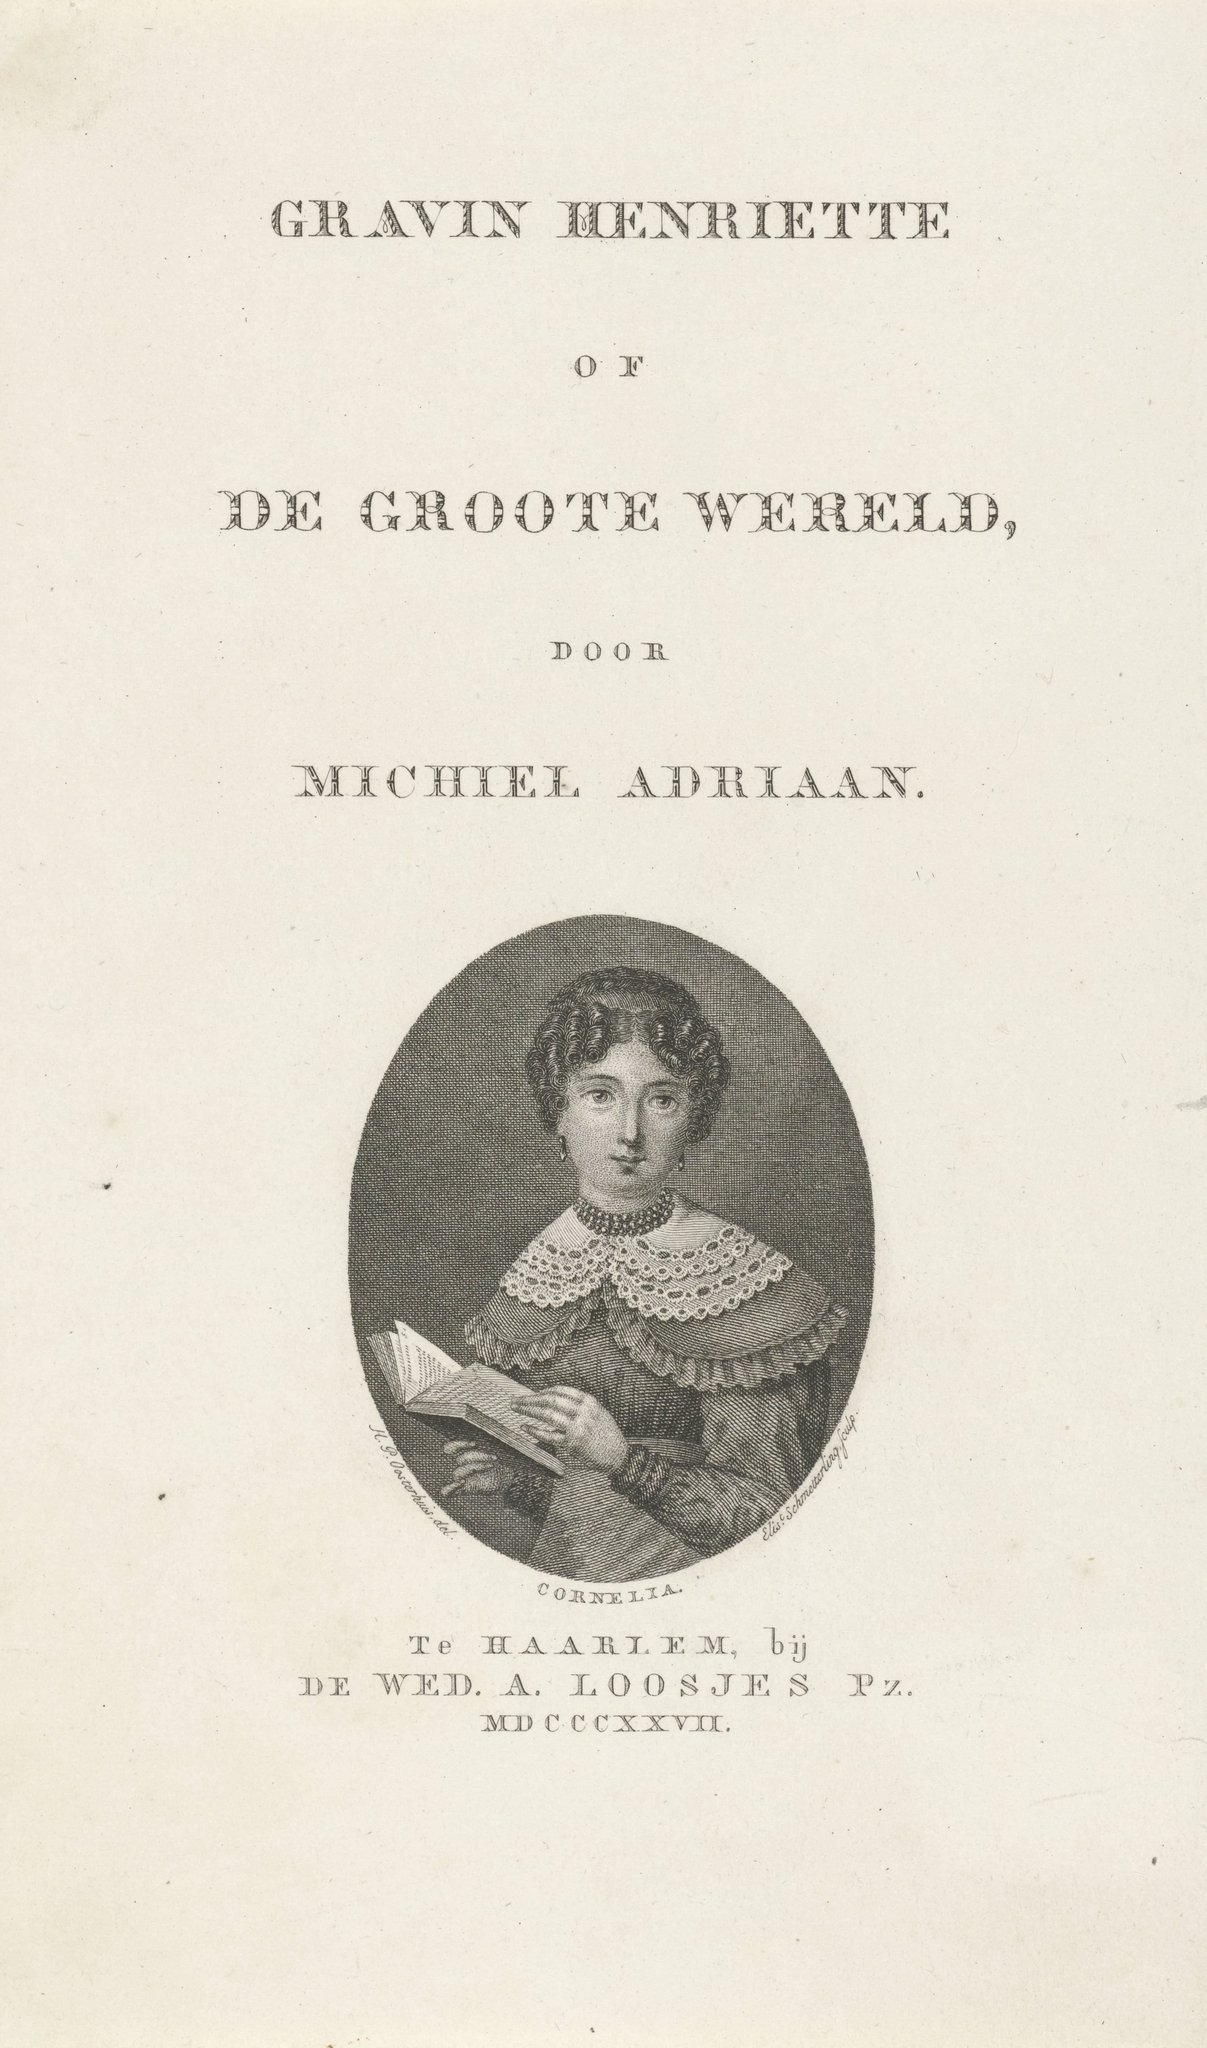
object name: print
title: Titelpagina voor Michel Adriaan, Gravin Henriette of De Groote Wereld, 1827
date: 1827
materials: paper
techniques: engraving, etching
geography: amsterdam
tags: reading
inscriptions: date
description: Titelpagina voor Michel Adriaan, Gravin Henriette of De Groote Wereld, 1827, met een portret van Cornelia die een boek leest.